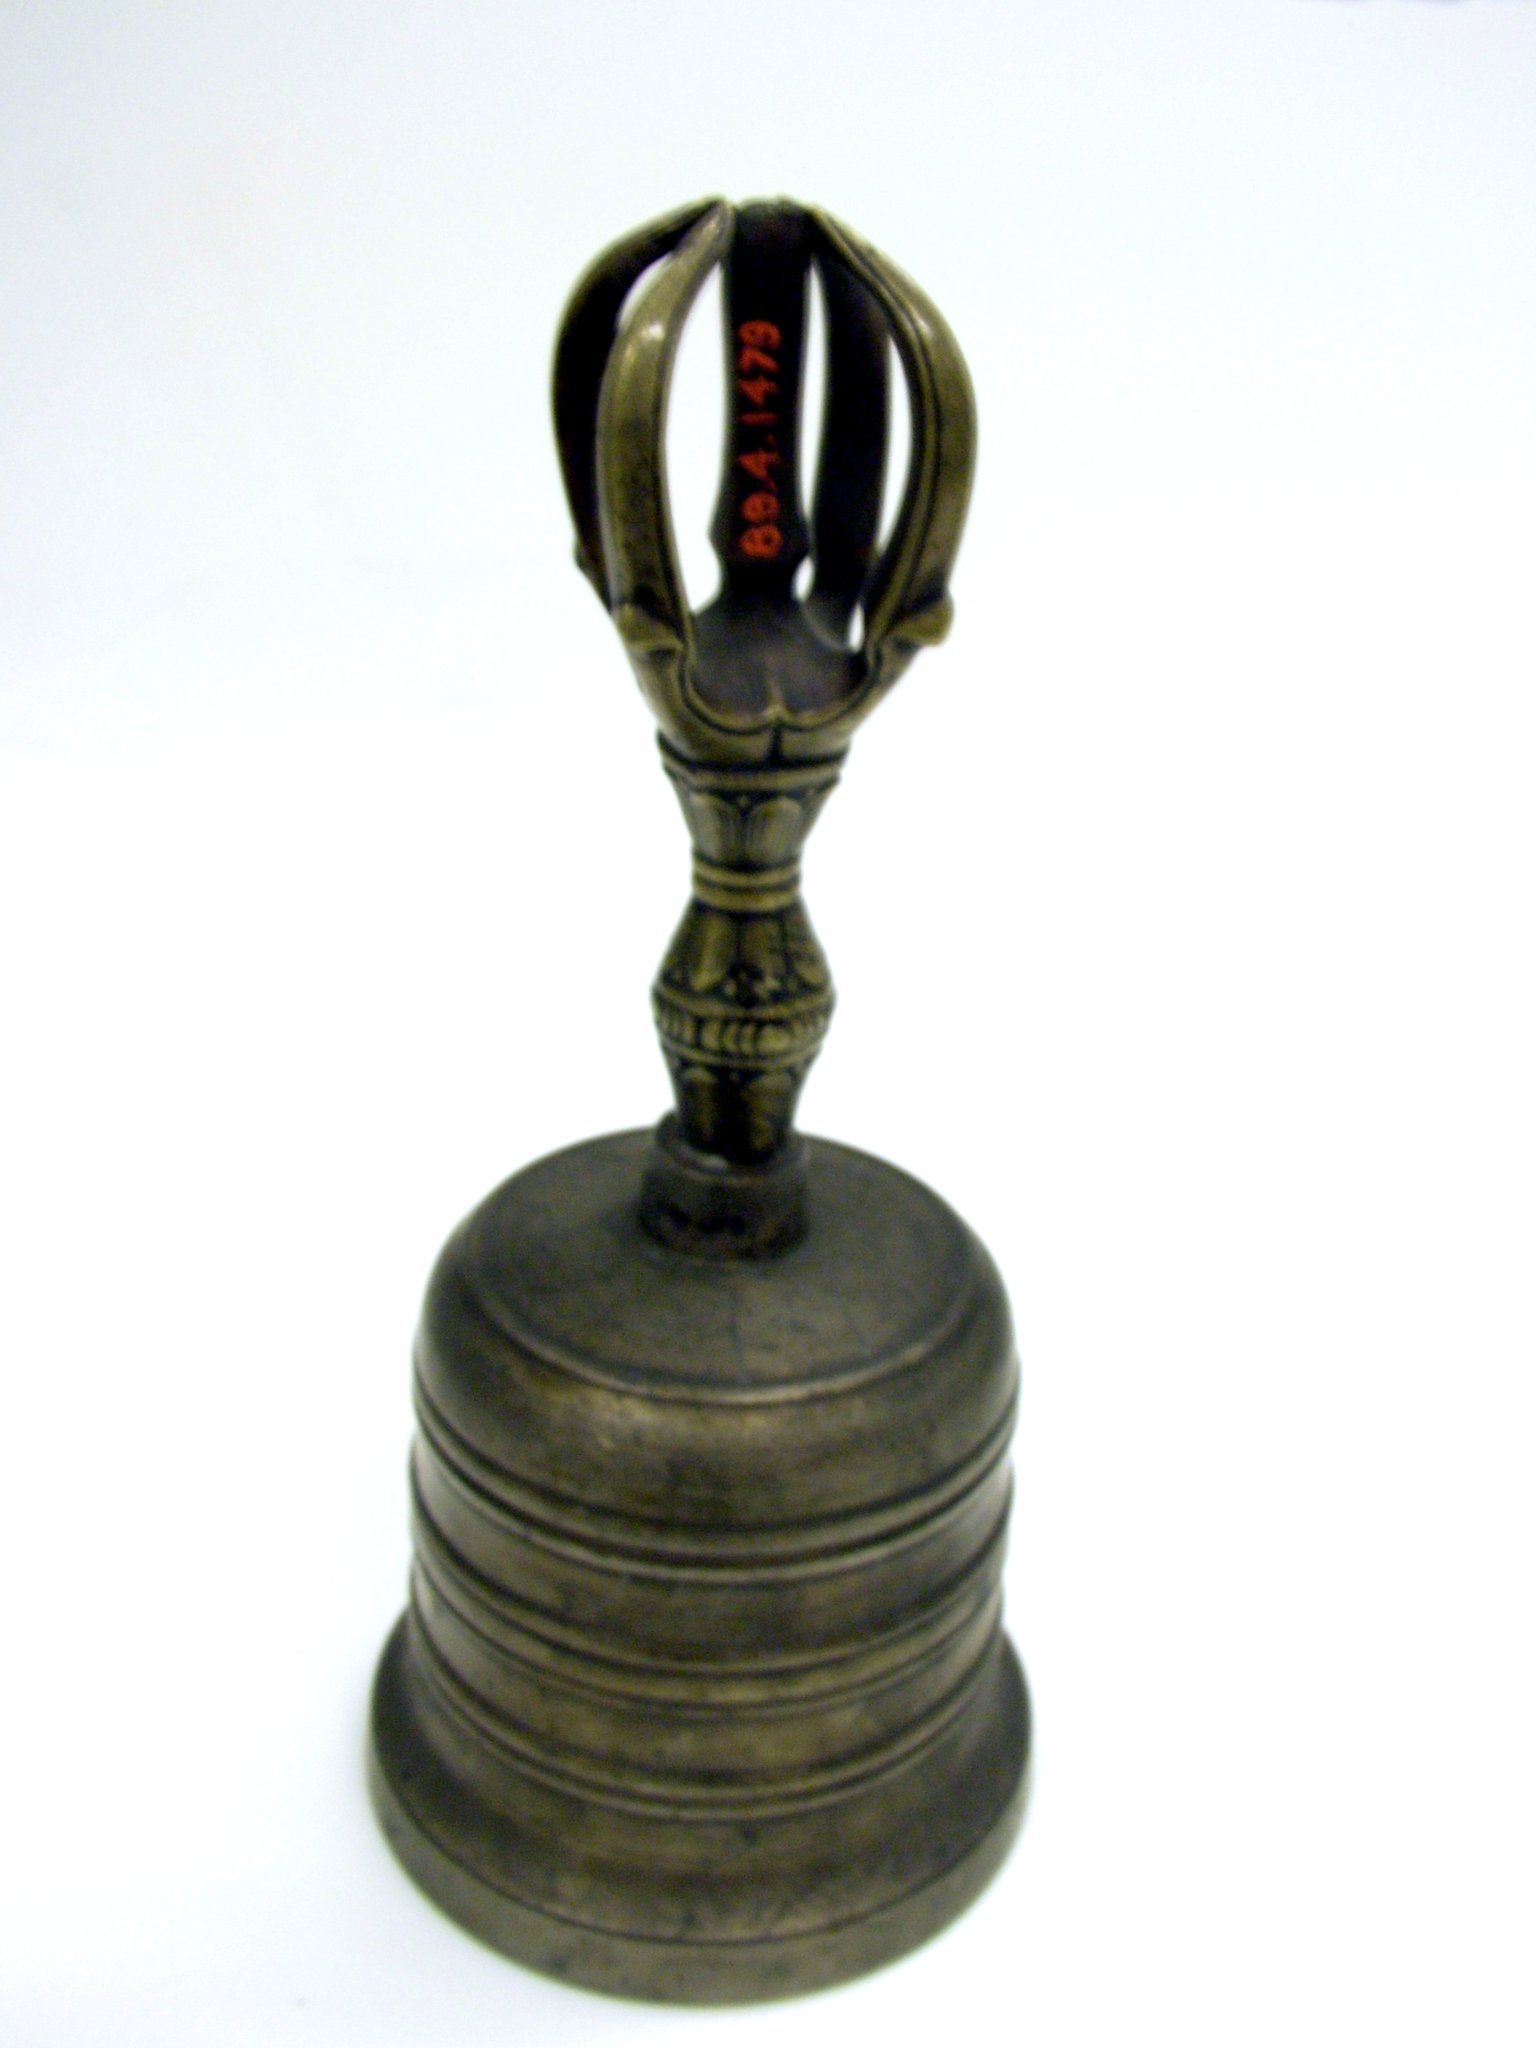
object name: bell rei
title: Bell (Rei)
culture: japanese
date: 1801-1900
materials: bronze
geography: japan